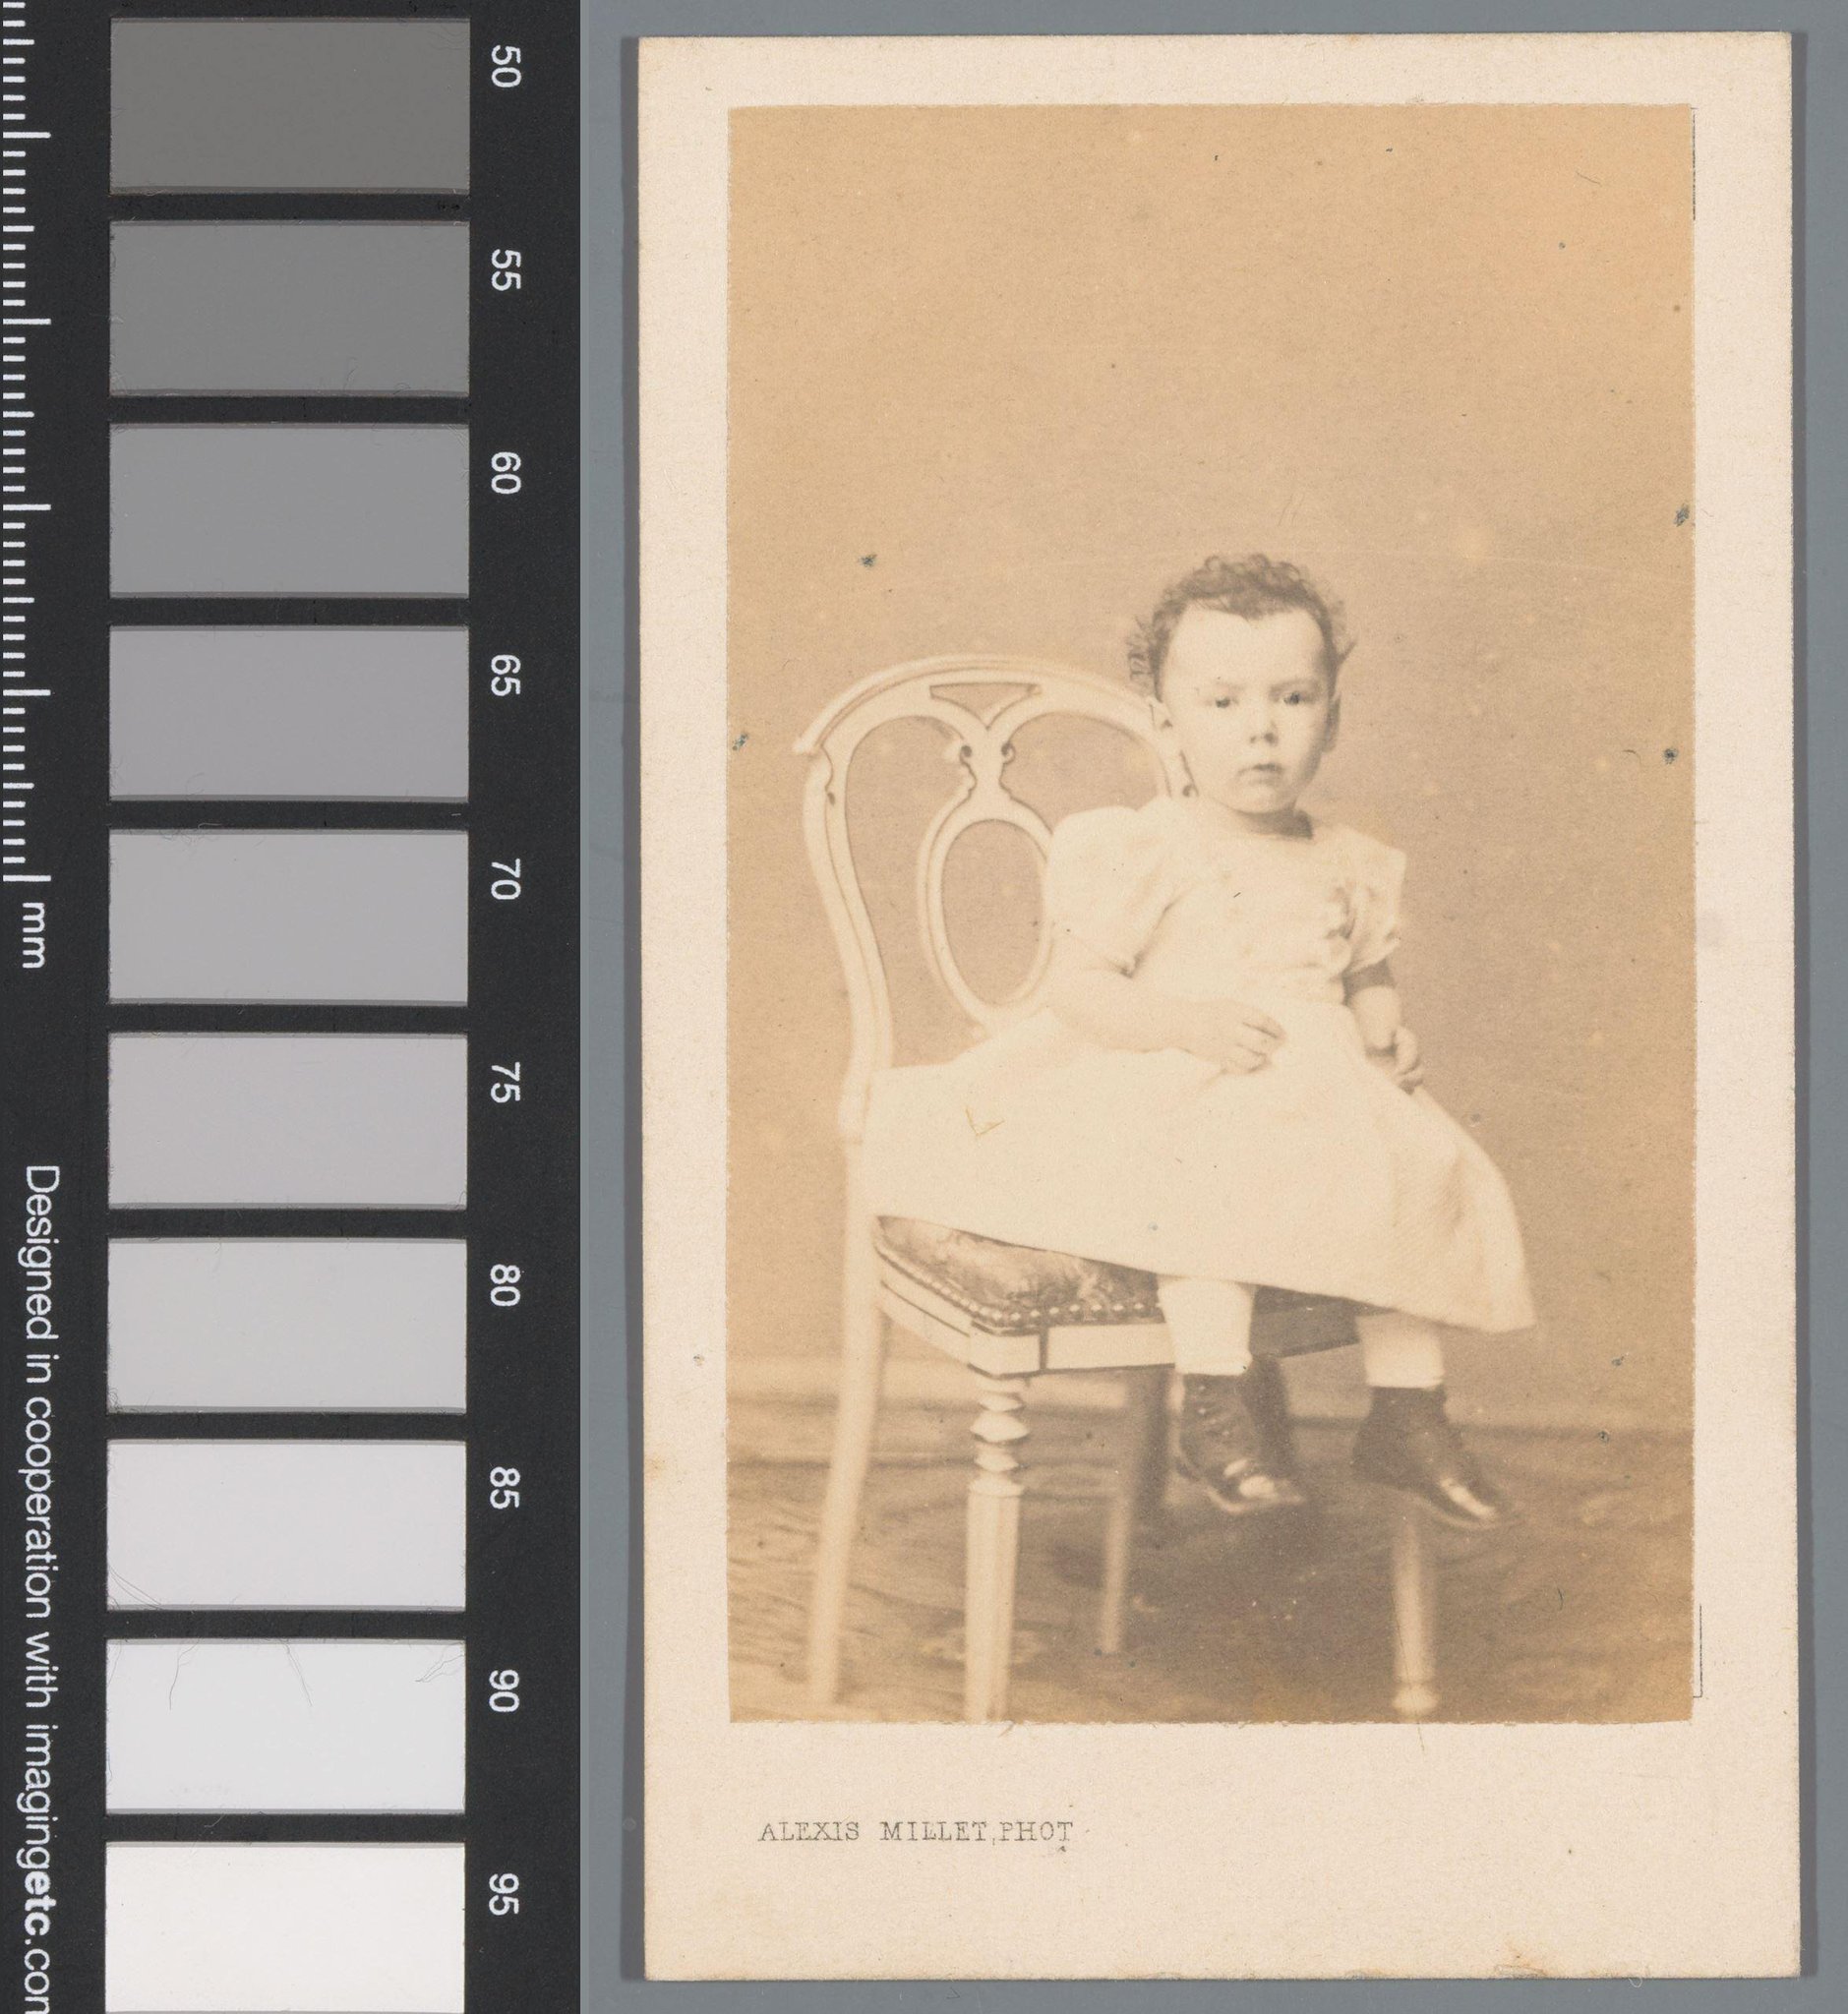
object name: photograph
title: Portret van een onbekend kind, zittend op een stoel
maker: alexis millet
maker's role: fotograaf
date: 1855-1885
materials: cardboard, paper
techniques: albumen print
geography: paris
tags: sitting figure, child, historical persons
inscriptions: inscription: ‘CLICHÉ NO/ PHOTOGRAPHIE FRANÇAISE/ AM/ ALEXIS MILLET/ 45, Boult St Martin 45,/ PARIS’